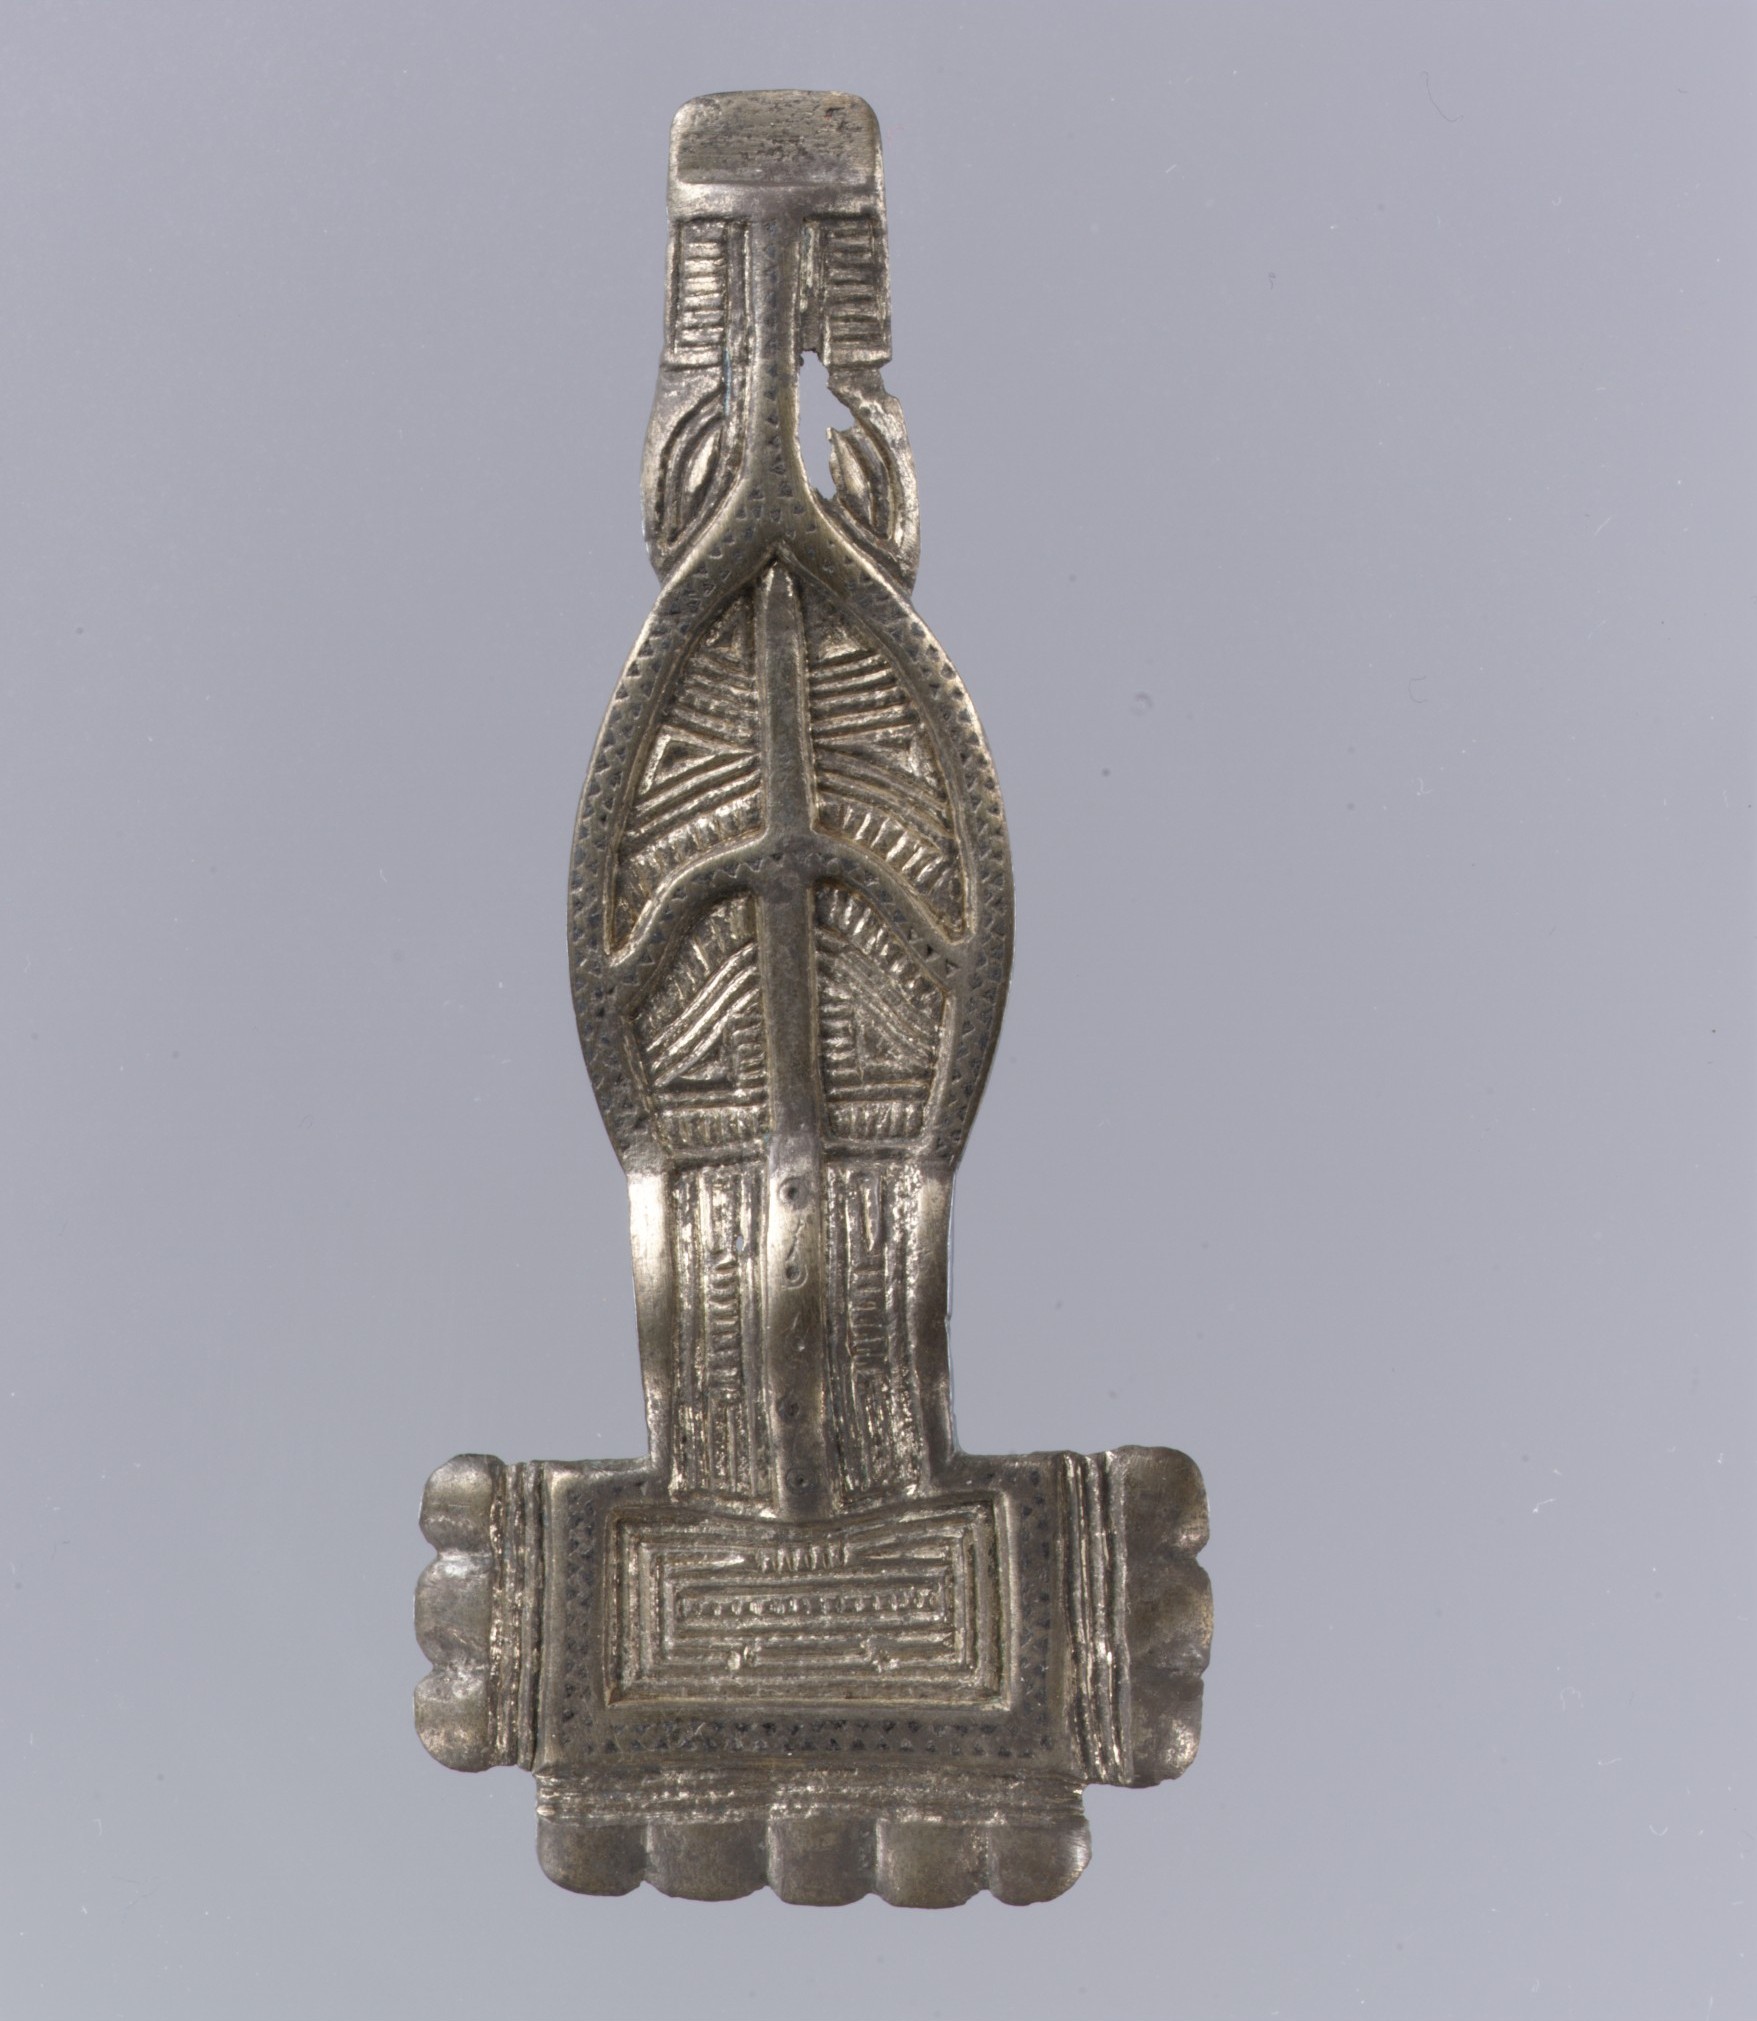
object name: brooch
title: Square-Headed Bow Brooch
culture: frankish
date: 551-600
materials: niello, silver gilt